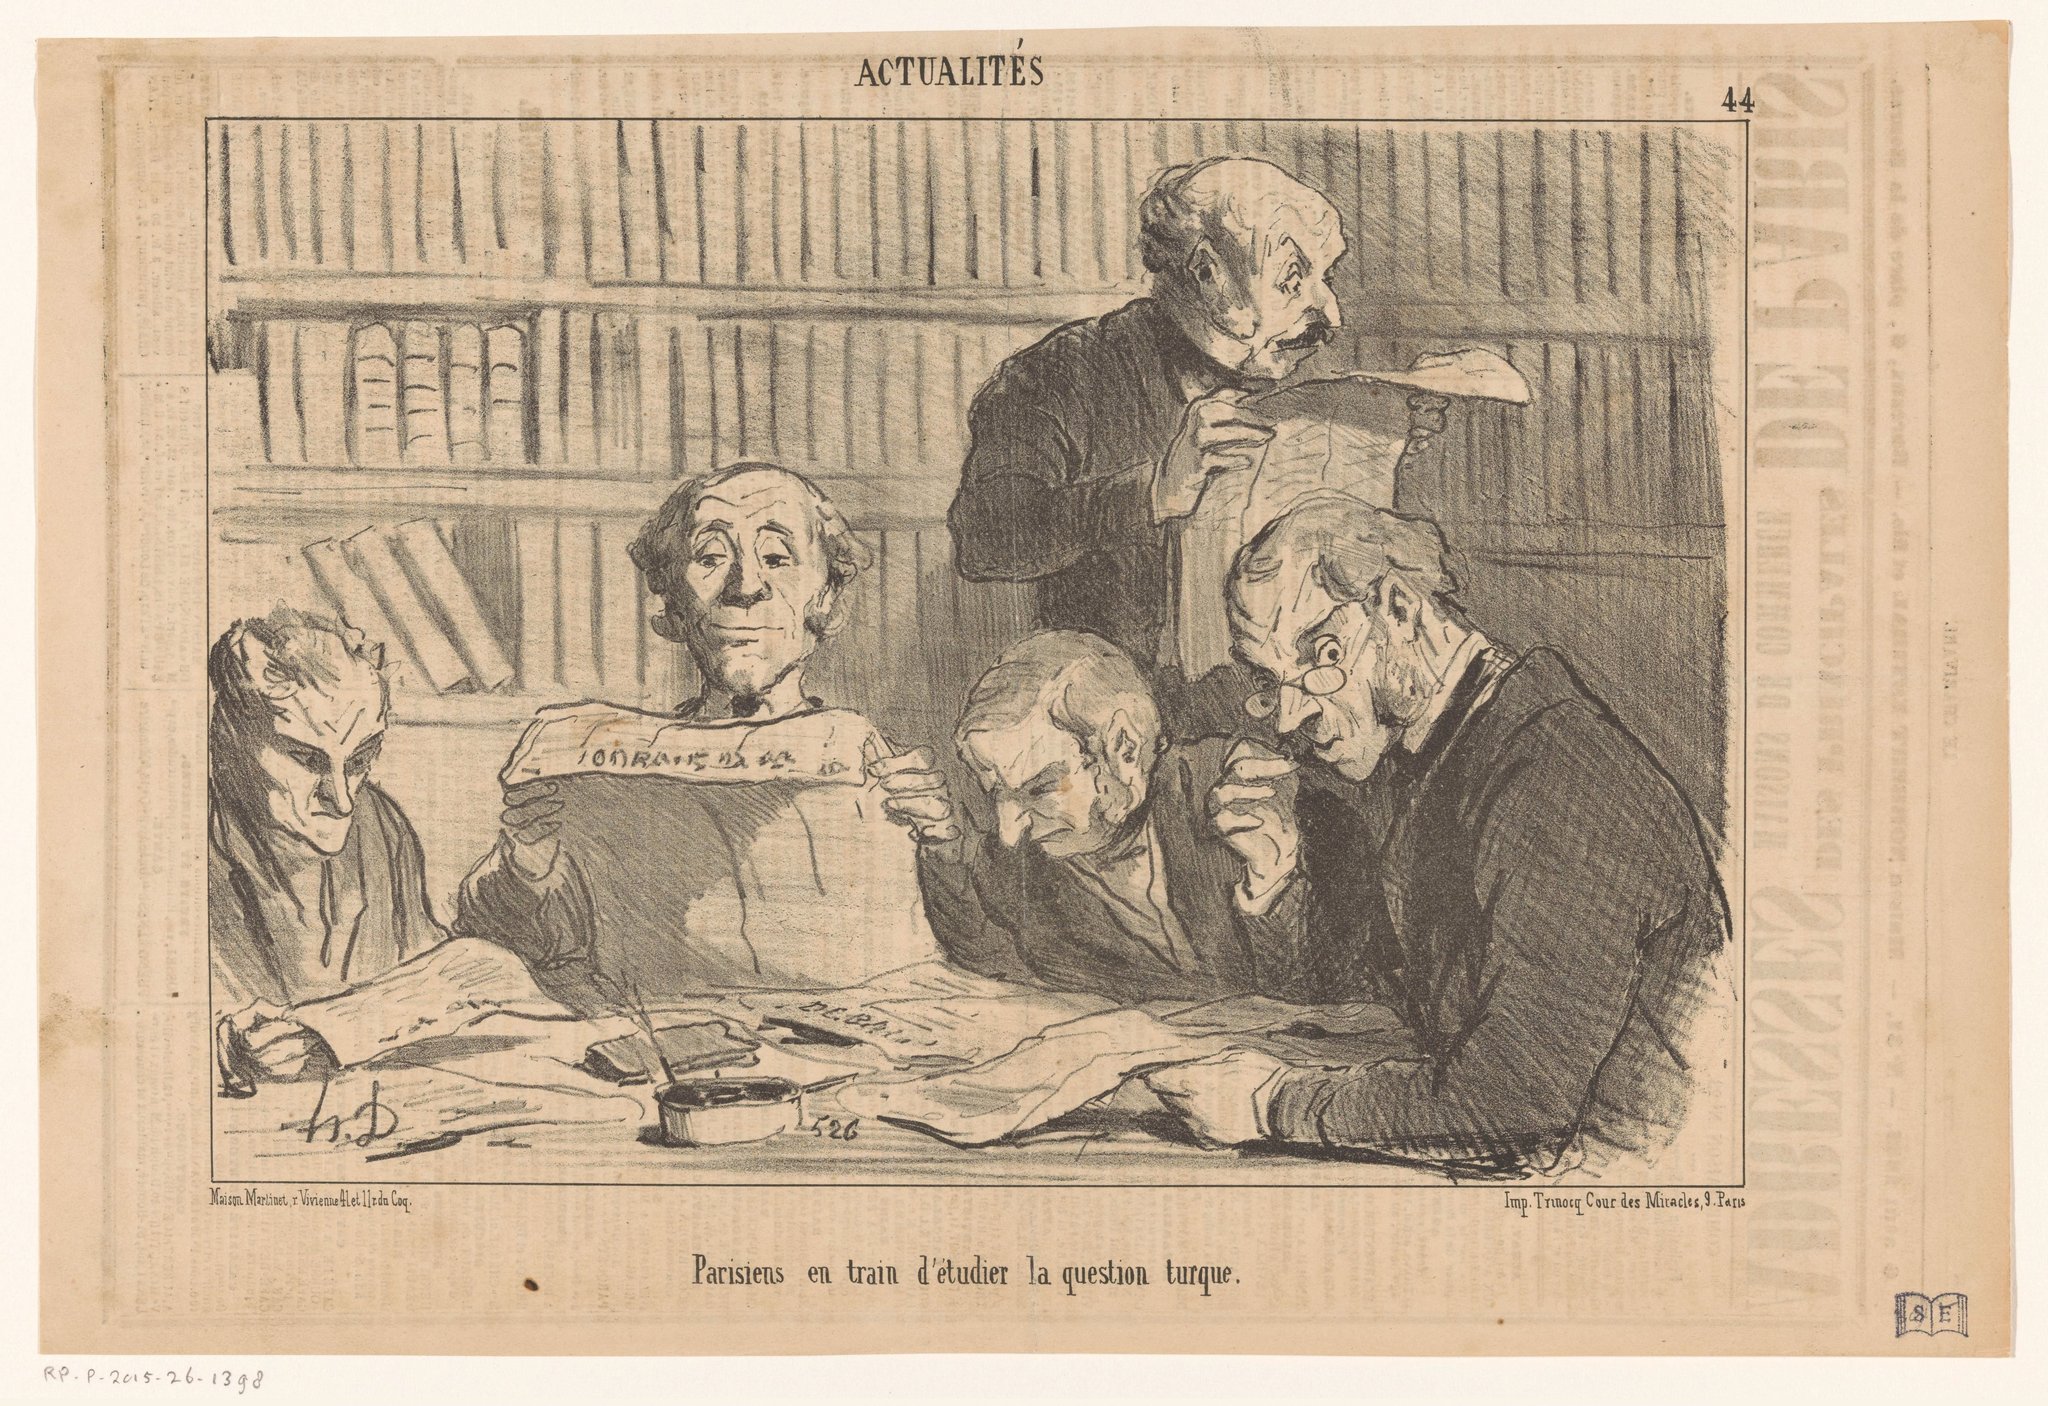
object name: print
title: Actualiteiten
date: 1808-1853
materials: paper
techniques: lithograph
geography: paris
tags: reading, newspaper, news-sheet, public library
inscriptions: collector's mark: Lugt 4779, collector's mark: Lugt 2228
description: Bibliotheekinterieur met vier mannen zittend aan een tafel en een staand voor een boekenkast. Tekst op verso.